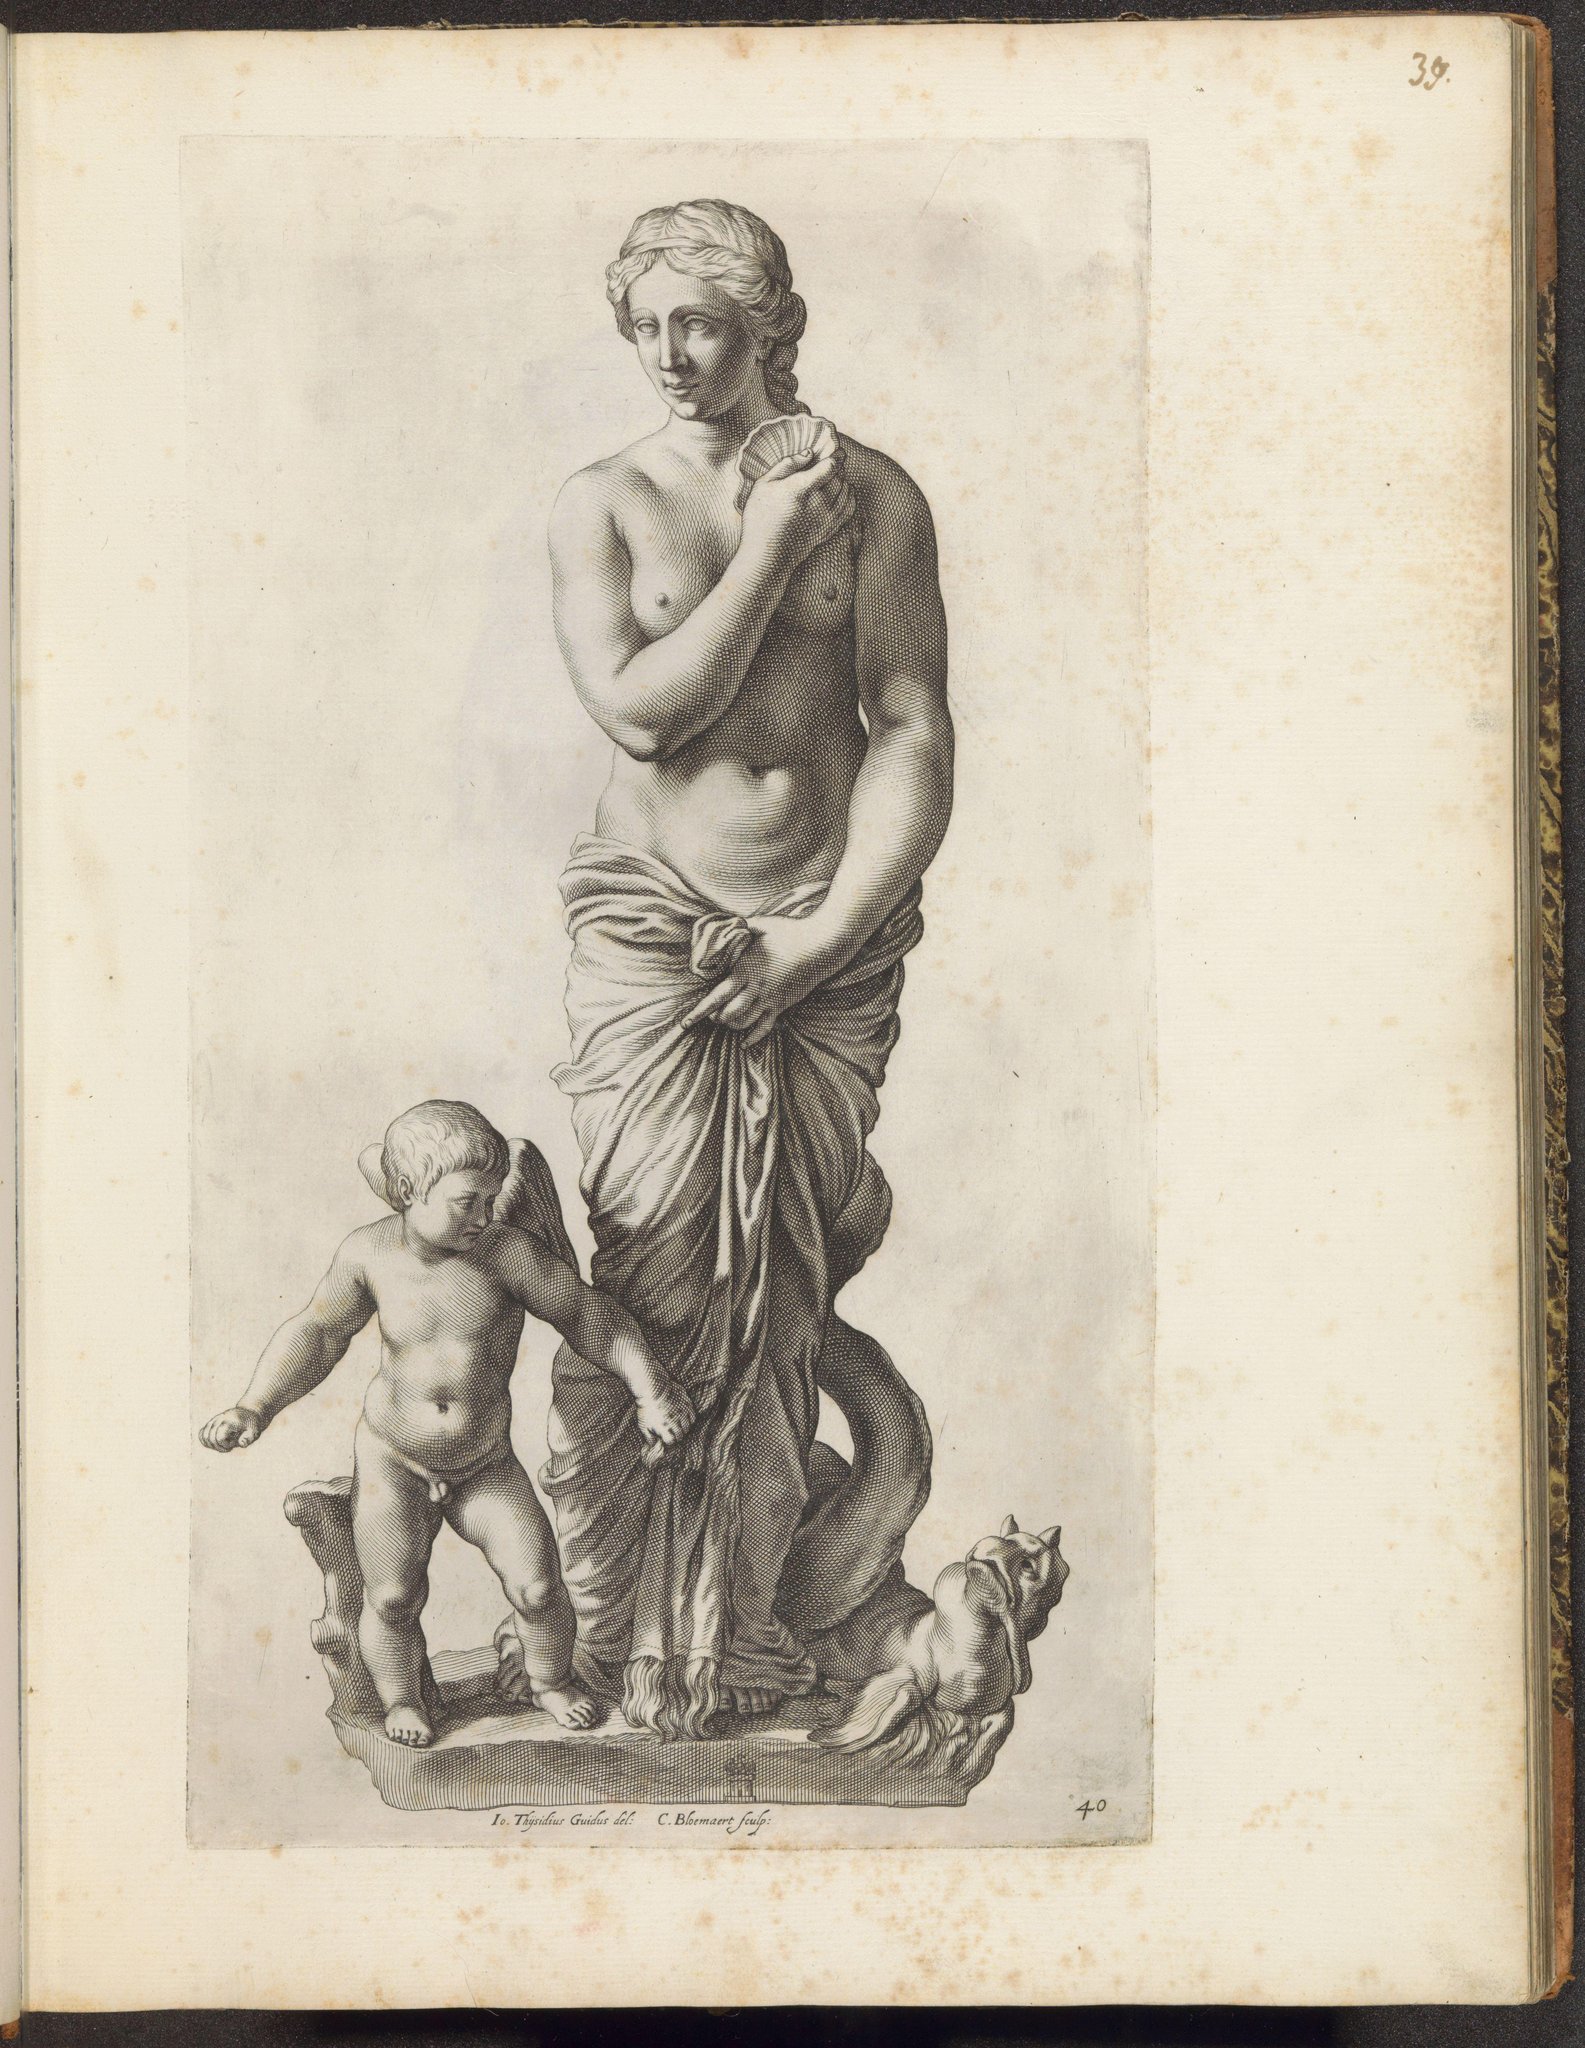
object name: album leaf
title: Standbeeld van Venus met Amor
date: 1636-1647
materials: paper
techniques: engraving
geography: rome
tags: piece of sculpture, reproduction of a piece of sculpture, (story of) venus (aphrodite), venus and cupid (cupid not being mere attribute)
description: Beeld van Venus die in haar rechterhand een schelp vasthoudt. Rechts van haar trekt Amor aan haar kleed. Links aan haar voeten een zeemonster. Op de basis het wapenschild van Vincenzo Giustiniani. Prent maakt deel uit van een album met een serie prenten naar de sculpturen in de verzameling in de Galleria Giustiniani te Rome.